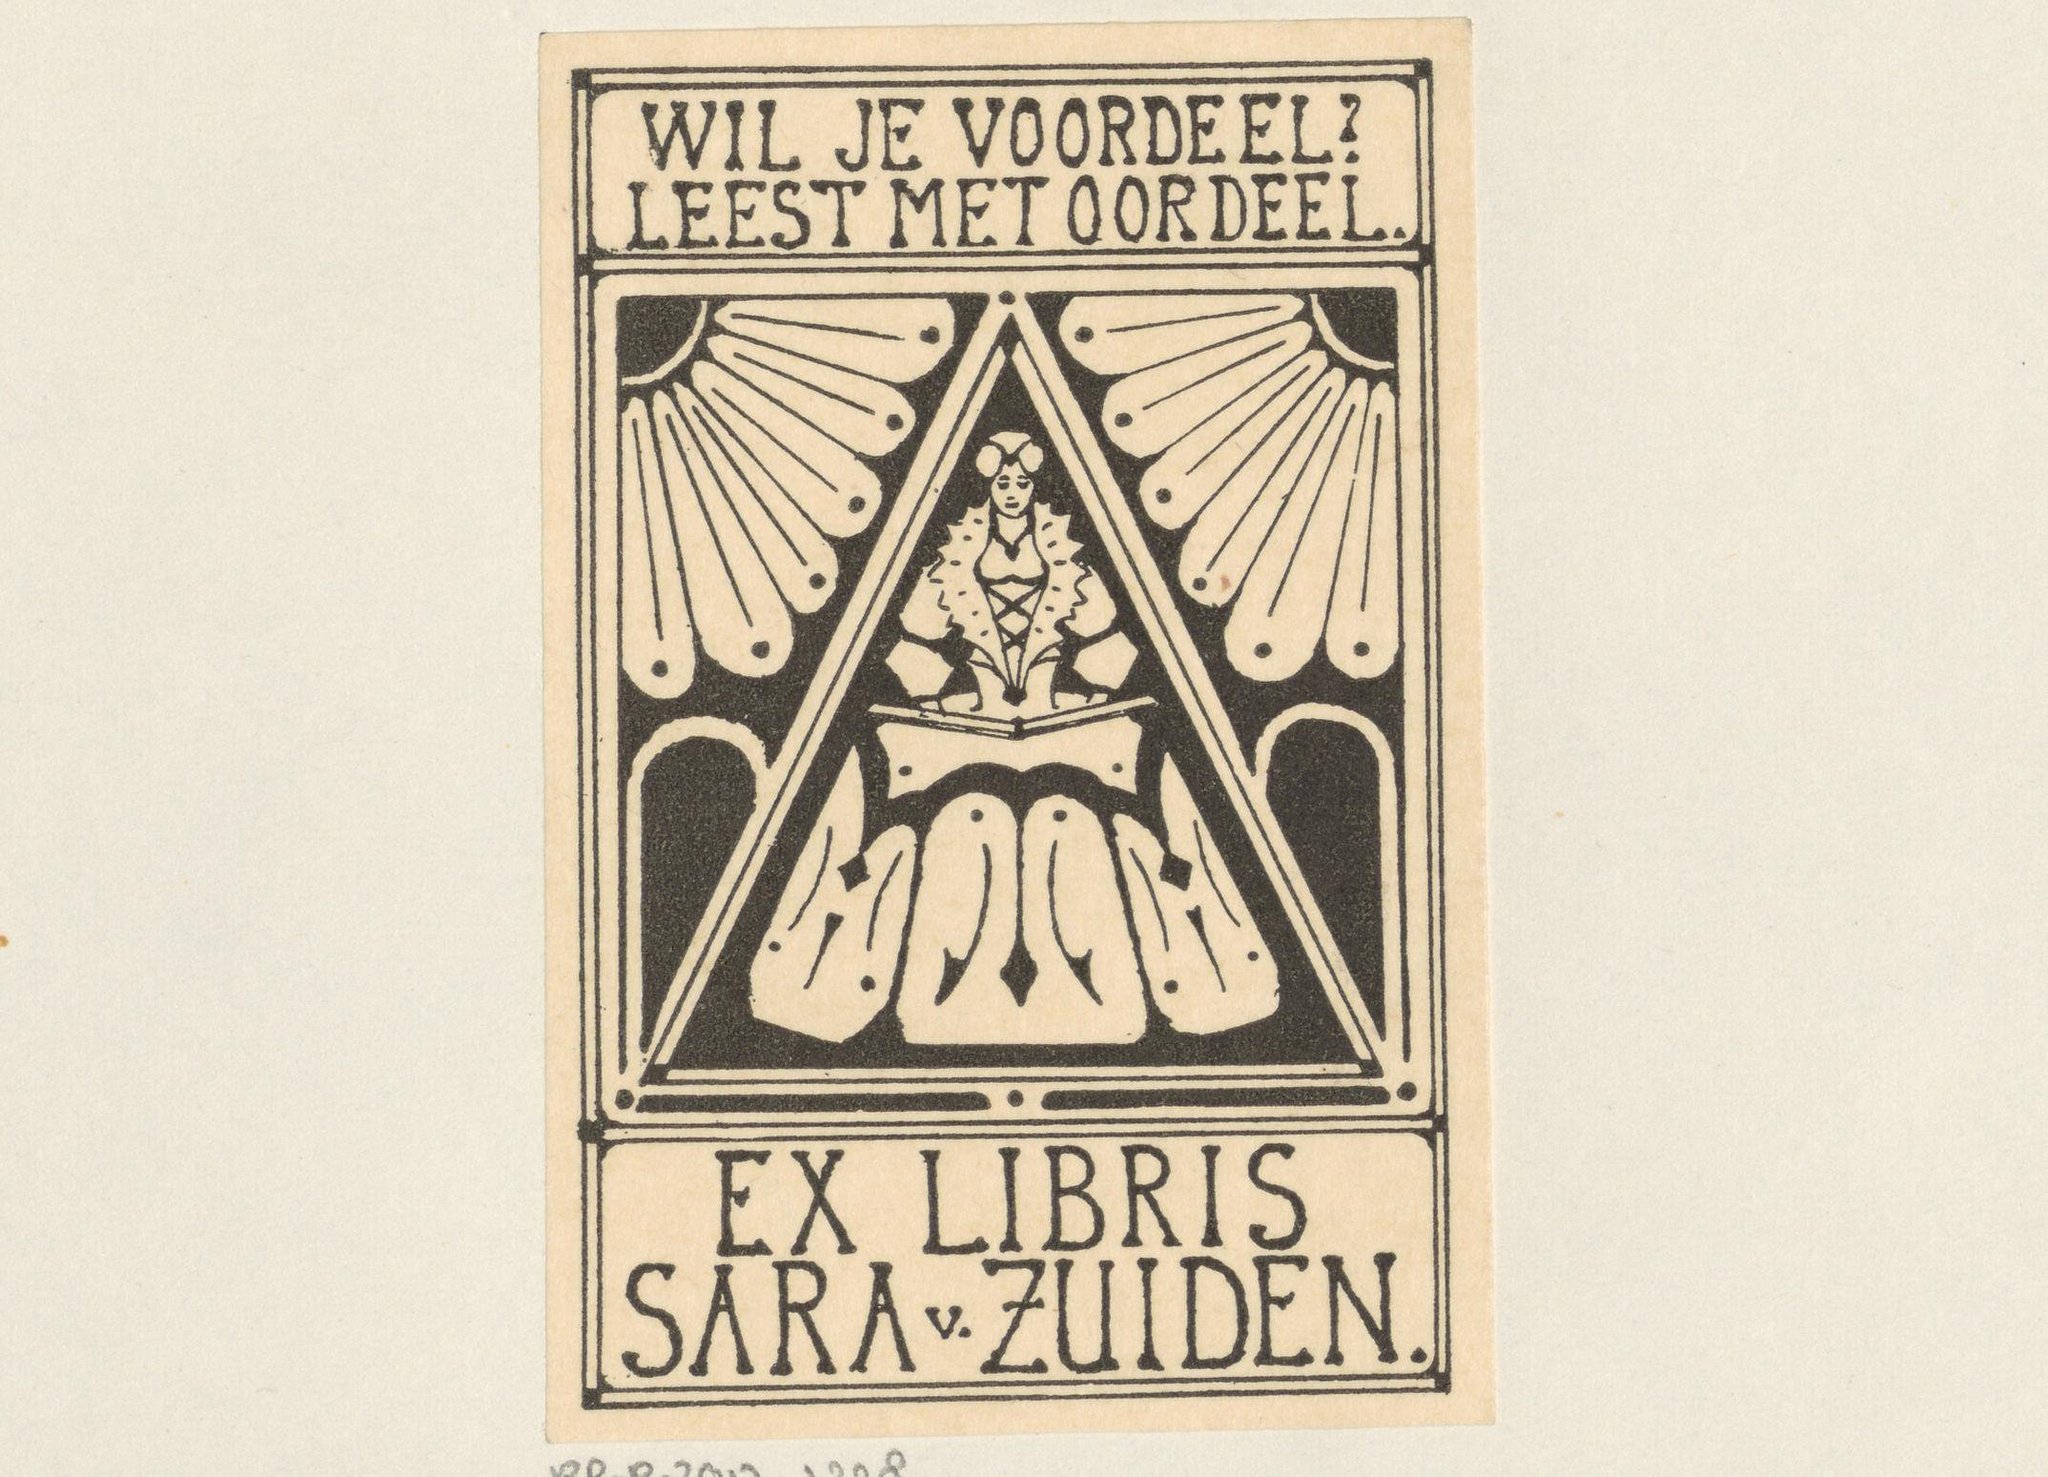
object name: bookplate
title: Ex libris van Sarah van Zuiden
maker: Anonymous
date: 1850-1950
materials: paper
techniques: printing block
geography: netherlands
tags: adult woman, reading, historical costume